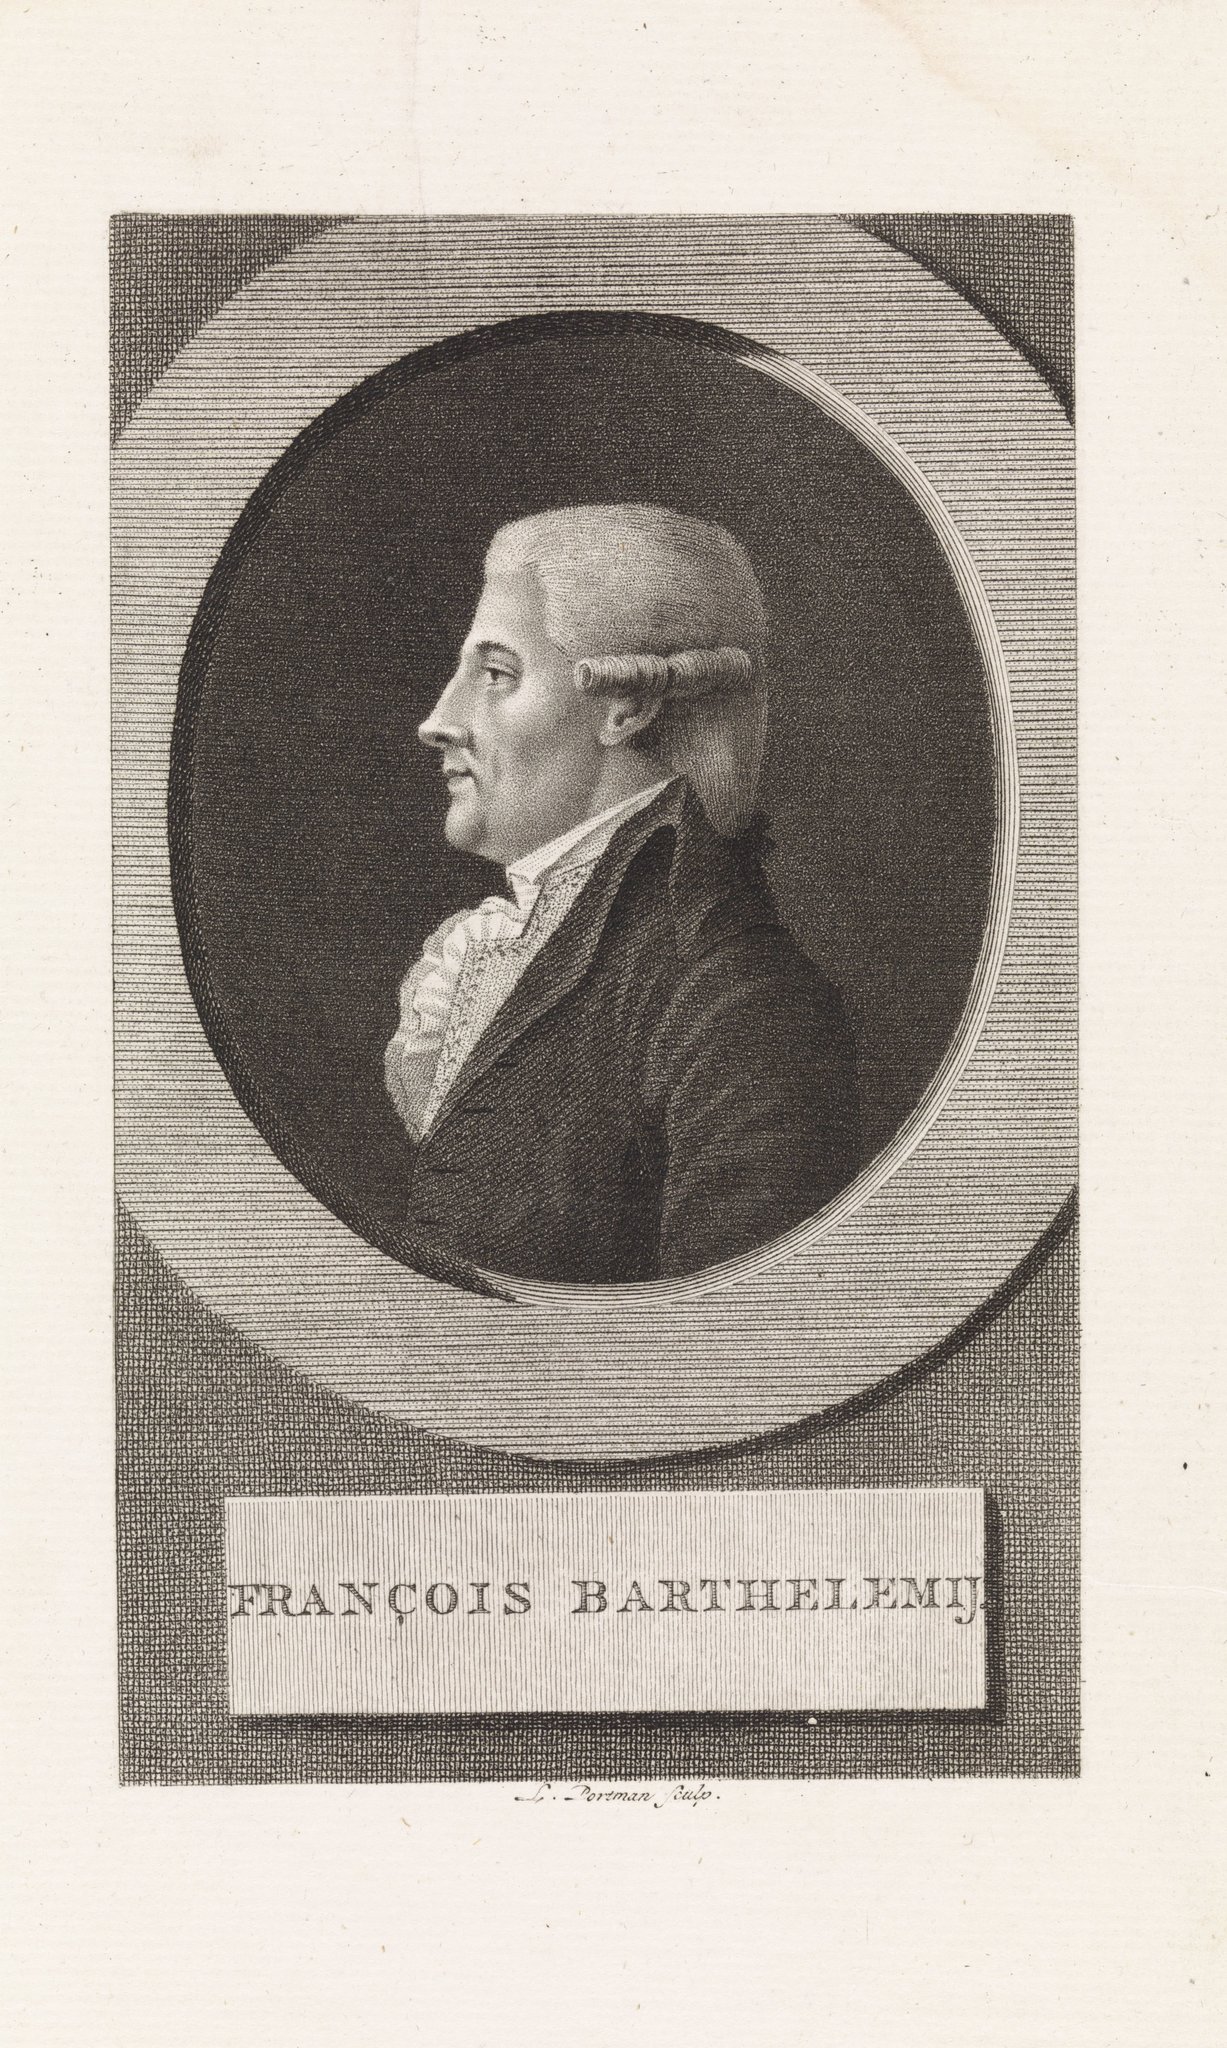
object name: print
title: Portret van de Franse diplomaat François Barthélemy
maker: ludwig gottlieb portman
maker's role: print maker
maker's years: 1772-1828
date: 1806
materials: paper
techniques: etching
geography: amsterdam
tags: politician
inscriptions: collector's mark: Lugt 2228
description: Prent ook gebruikt als illustratie in: Tafereelen van de staatsomwenteling in Frankrijk, deel 22, p. 132. Amsterdam: Johannes Allart, 1806.